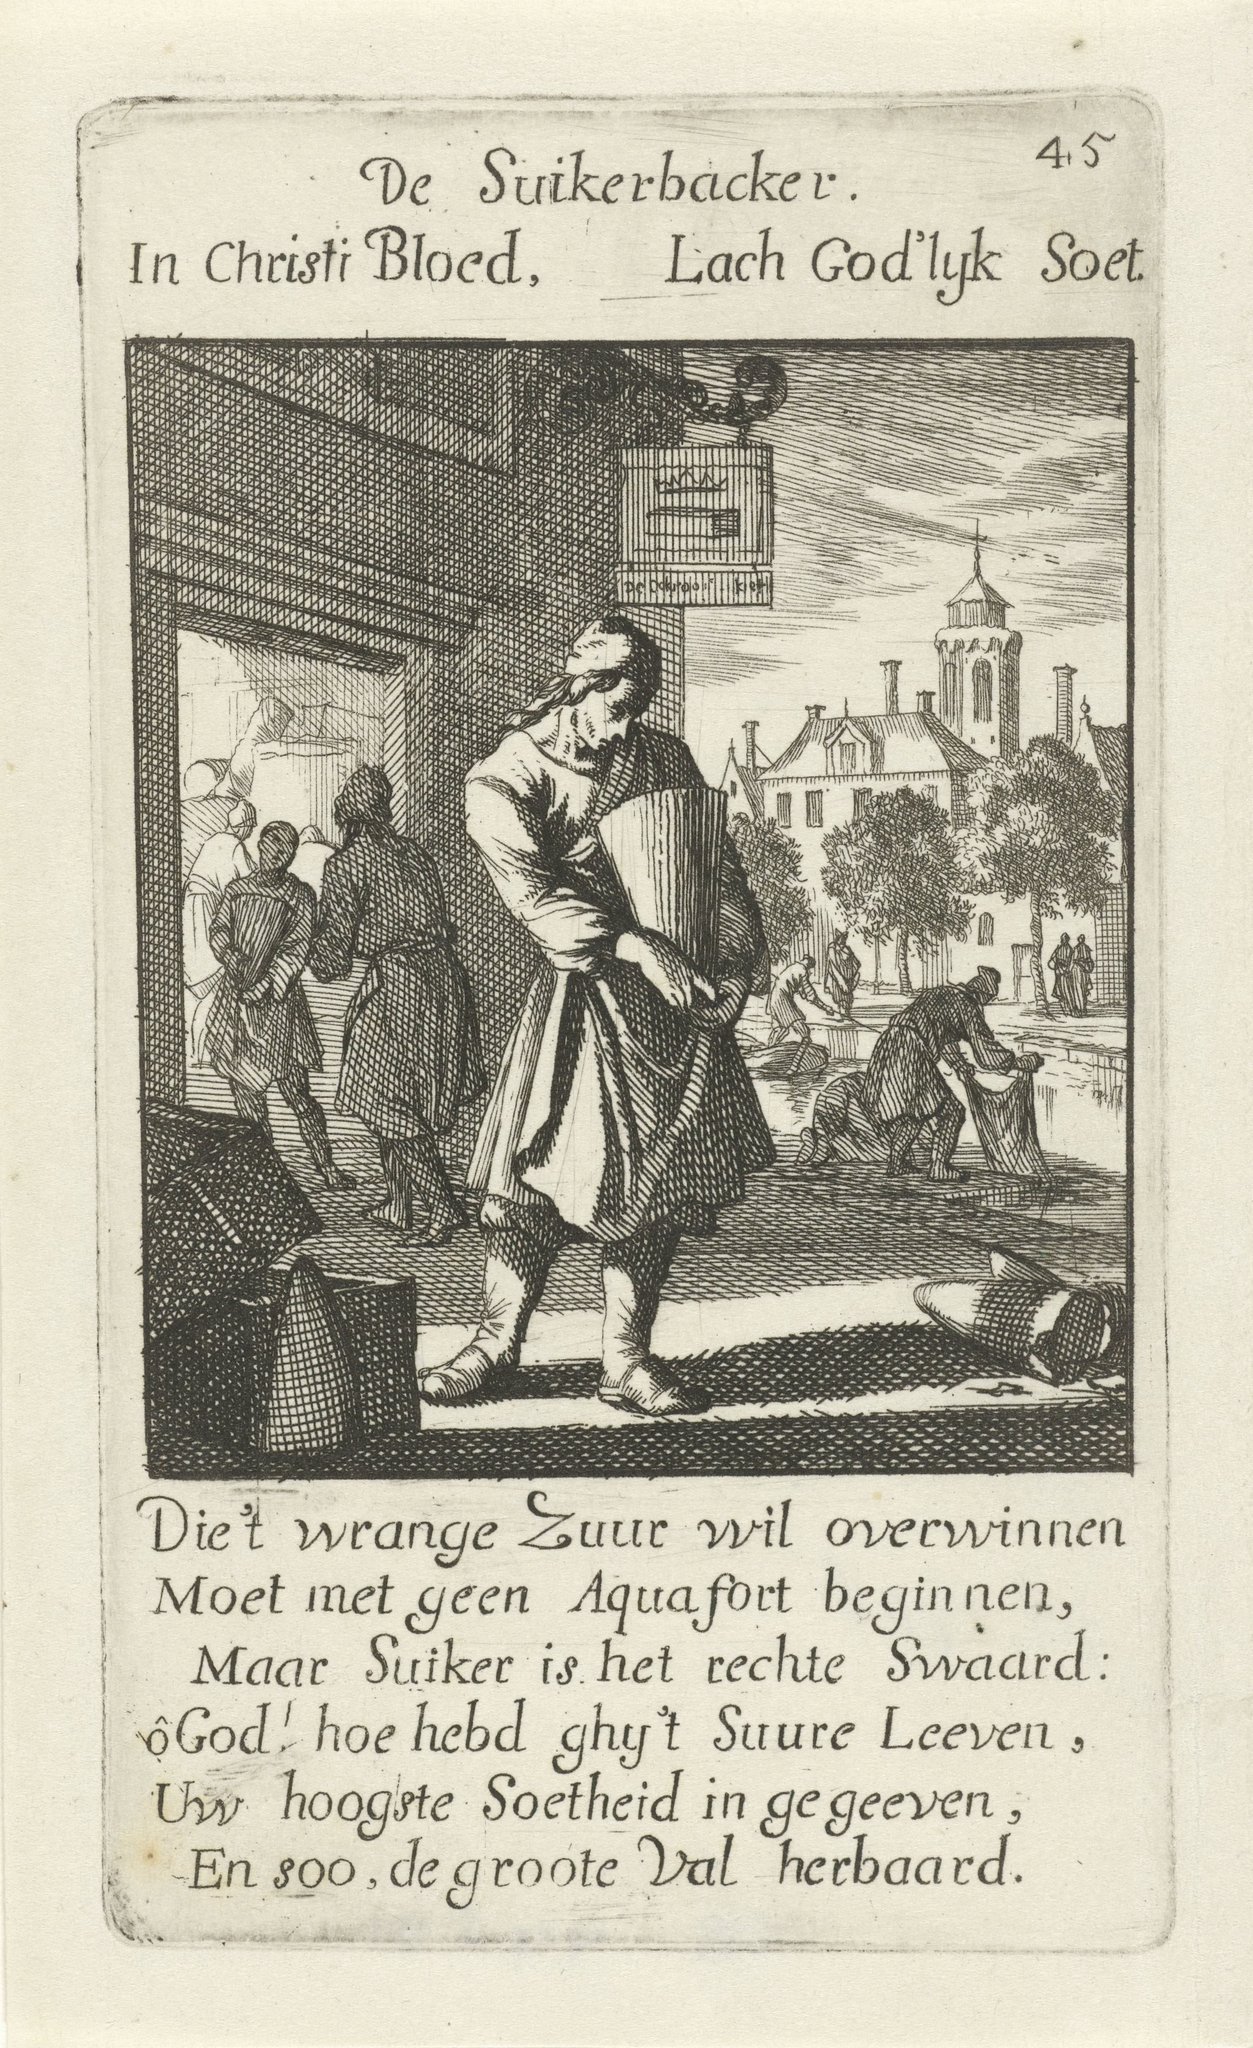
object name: print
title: Het Menselyk Bedryf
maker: jan luyken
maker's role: draughtsman, print maker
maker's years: 1649-1712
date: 1694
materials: paper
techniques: etching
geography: amsterdam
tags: handicrafts, craftsman at work, loaf-sugar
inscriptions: collector's mark: Lugt 2228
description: Maakt deel uit van de 100-delige serie beroepsprenten van Jan en Caspar Luyken, getiteld: Het menselyk bedryf. S.l.s.n., 1694 (eerste druk).